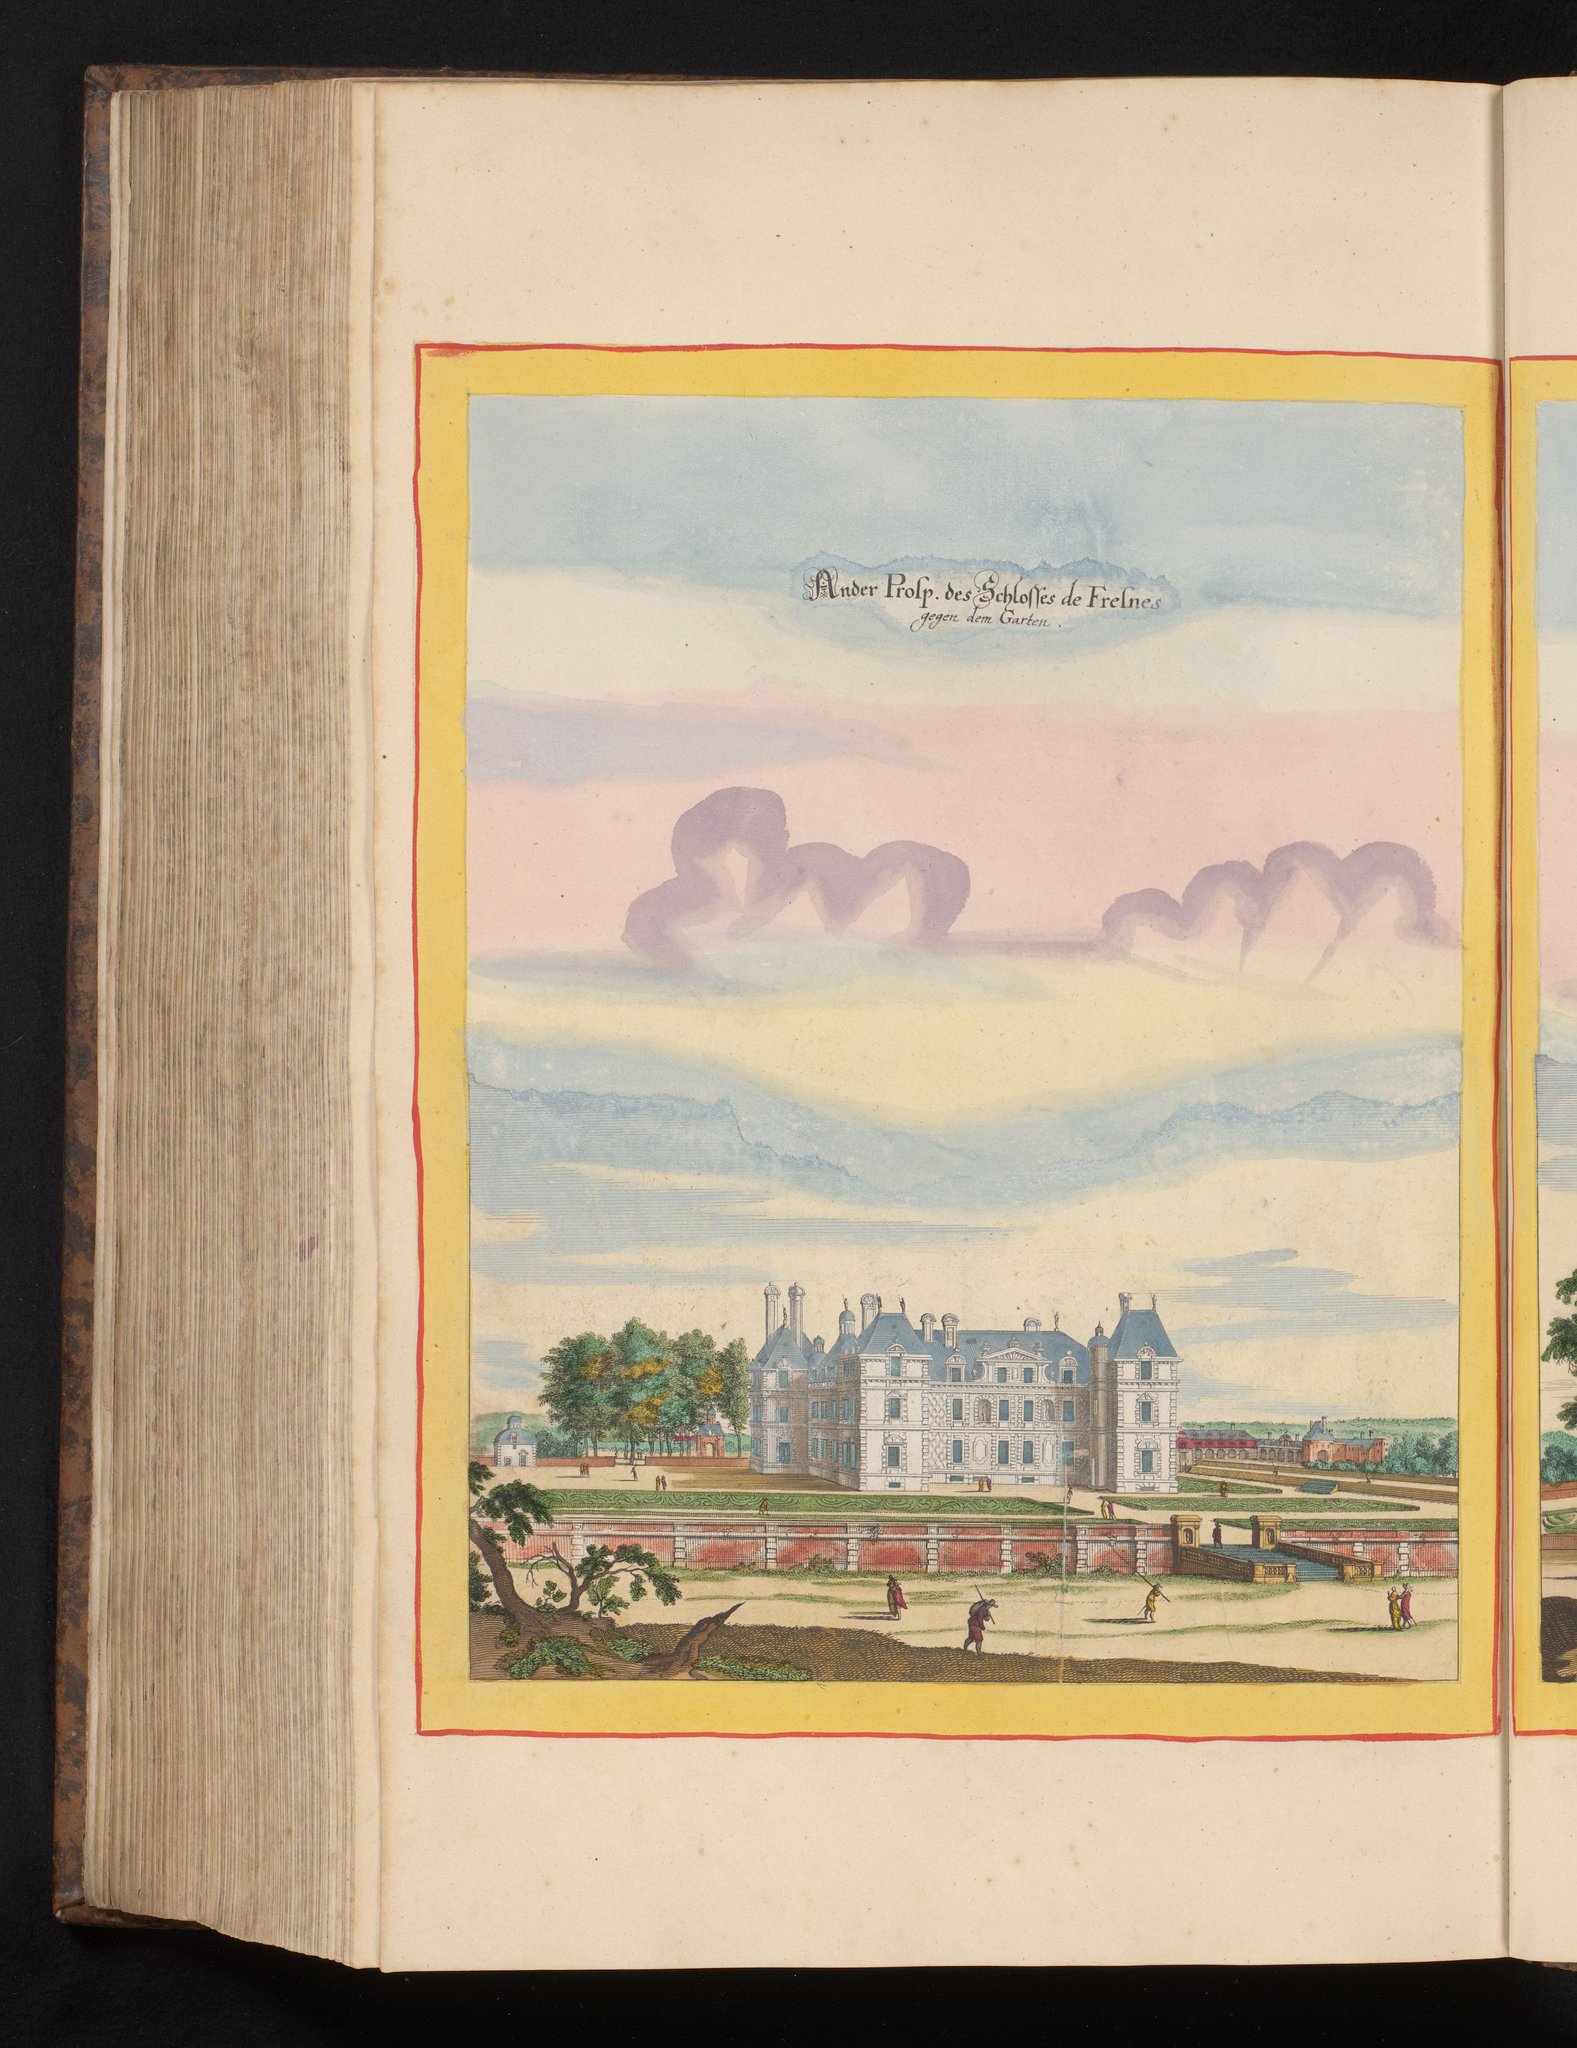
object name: album leaf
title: Prosp. dess Schlosses d'Escouan 5 Meijlen von Parijs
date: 1655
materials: paper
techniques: engraving, etching, hand coloring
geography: the hague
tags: castle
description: Prent origineel vervaardigd als boekillustratie voor: Zeiller, Martin. Topographia Galliae, oder Beschreibung und Contrafaitung der vornehmbsten und bekantisten Oerter in dem mächtigen und grossen Königreich Frankreich, 13 delen. Frankfurt am Main: Caspar Merian, 1655-1661. De prent werd voor het eerst gepubliceerd in deel 1: Topographia Galliae, 1655. De prent is langs de bovenrand van de voorstelling afgescheurd. De titel is hoger opgeplakt. De voorstelling is aan de bovenzijde aangevuld met een geschilderde lucht.